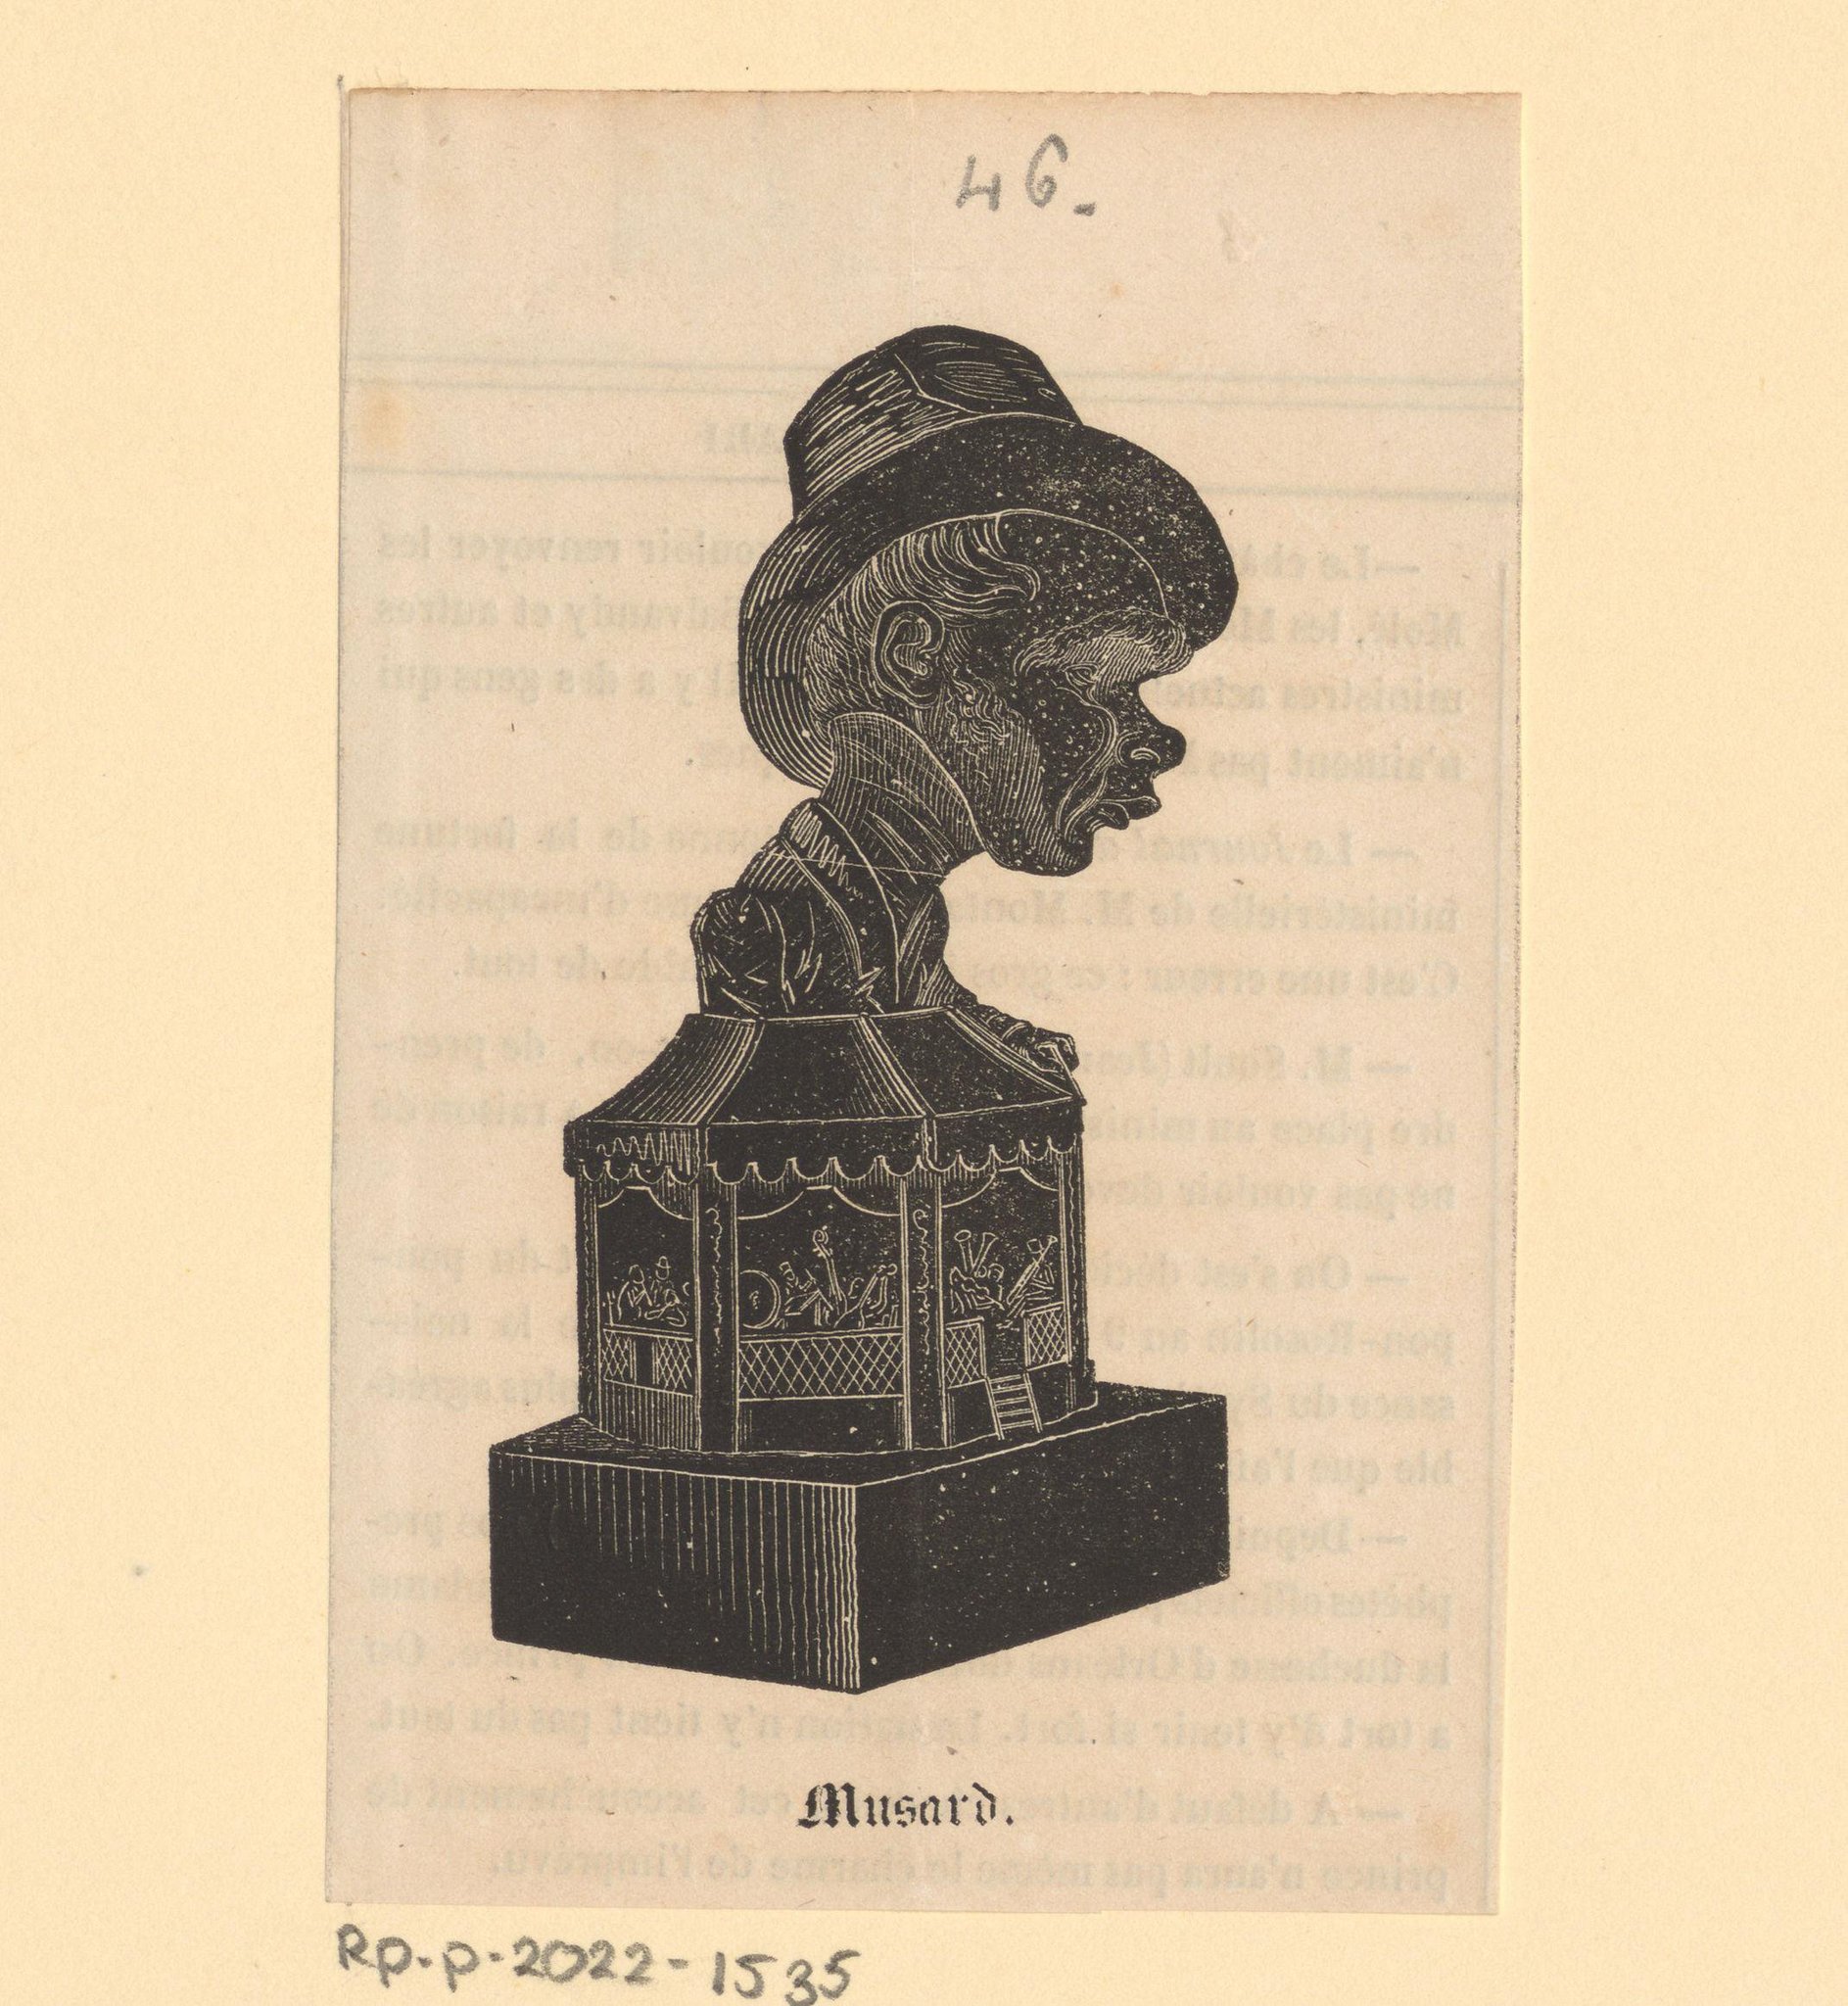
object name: print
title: Musard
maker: Anonymous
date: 1832-1937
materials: paper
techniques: letterpress printing, engraving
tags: historical persons, portrait of composer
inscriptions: number: ‘46.’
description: Prent uit een publicatie van: Le Charivari (1832-1937).